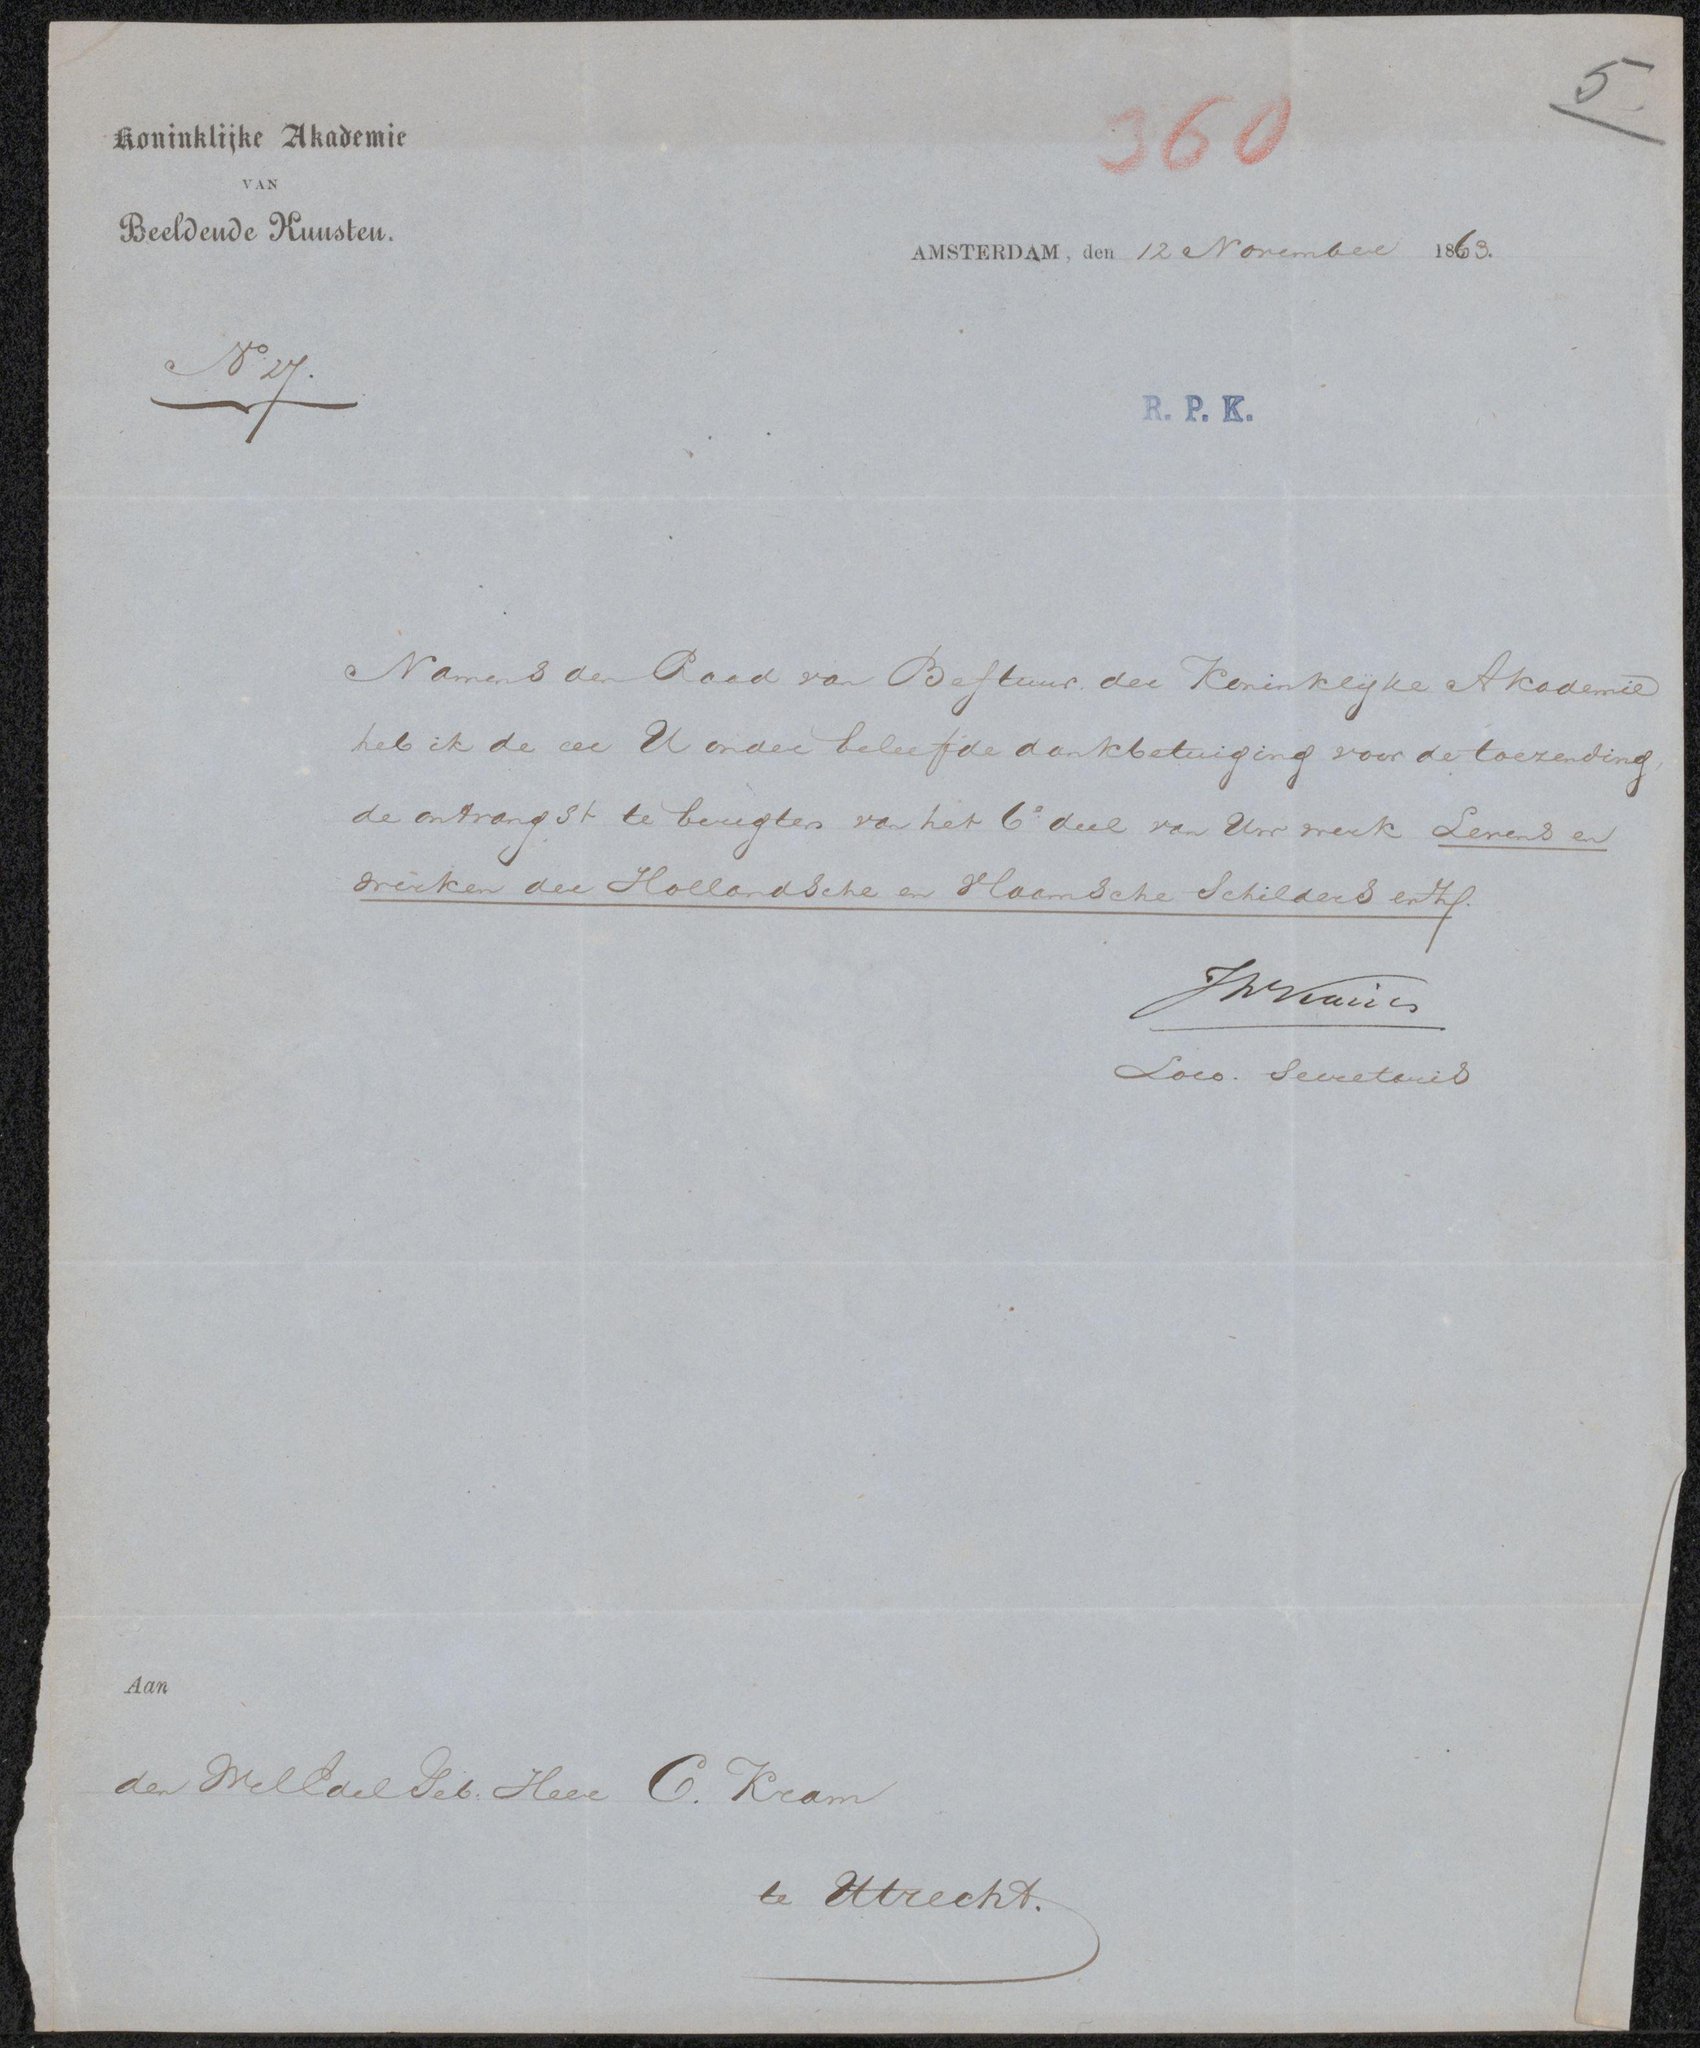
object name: letter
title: Brief aan Christiaan Kramm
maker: johann wilhelm kaiser (i)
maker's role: draughtsman, print maker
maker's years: 1813-1900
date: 1863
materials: ink, paper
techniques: pen, printing, writing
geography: amsterdam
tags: utrecht, draughtsman, christiaan kramm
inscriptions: watermark, collector's mark: Lugt 2233